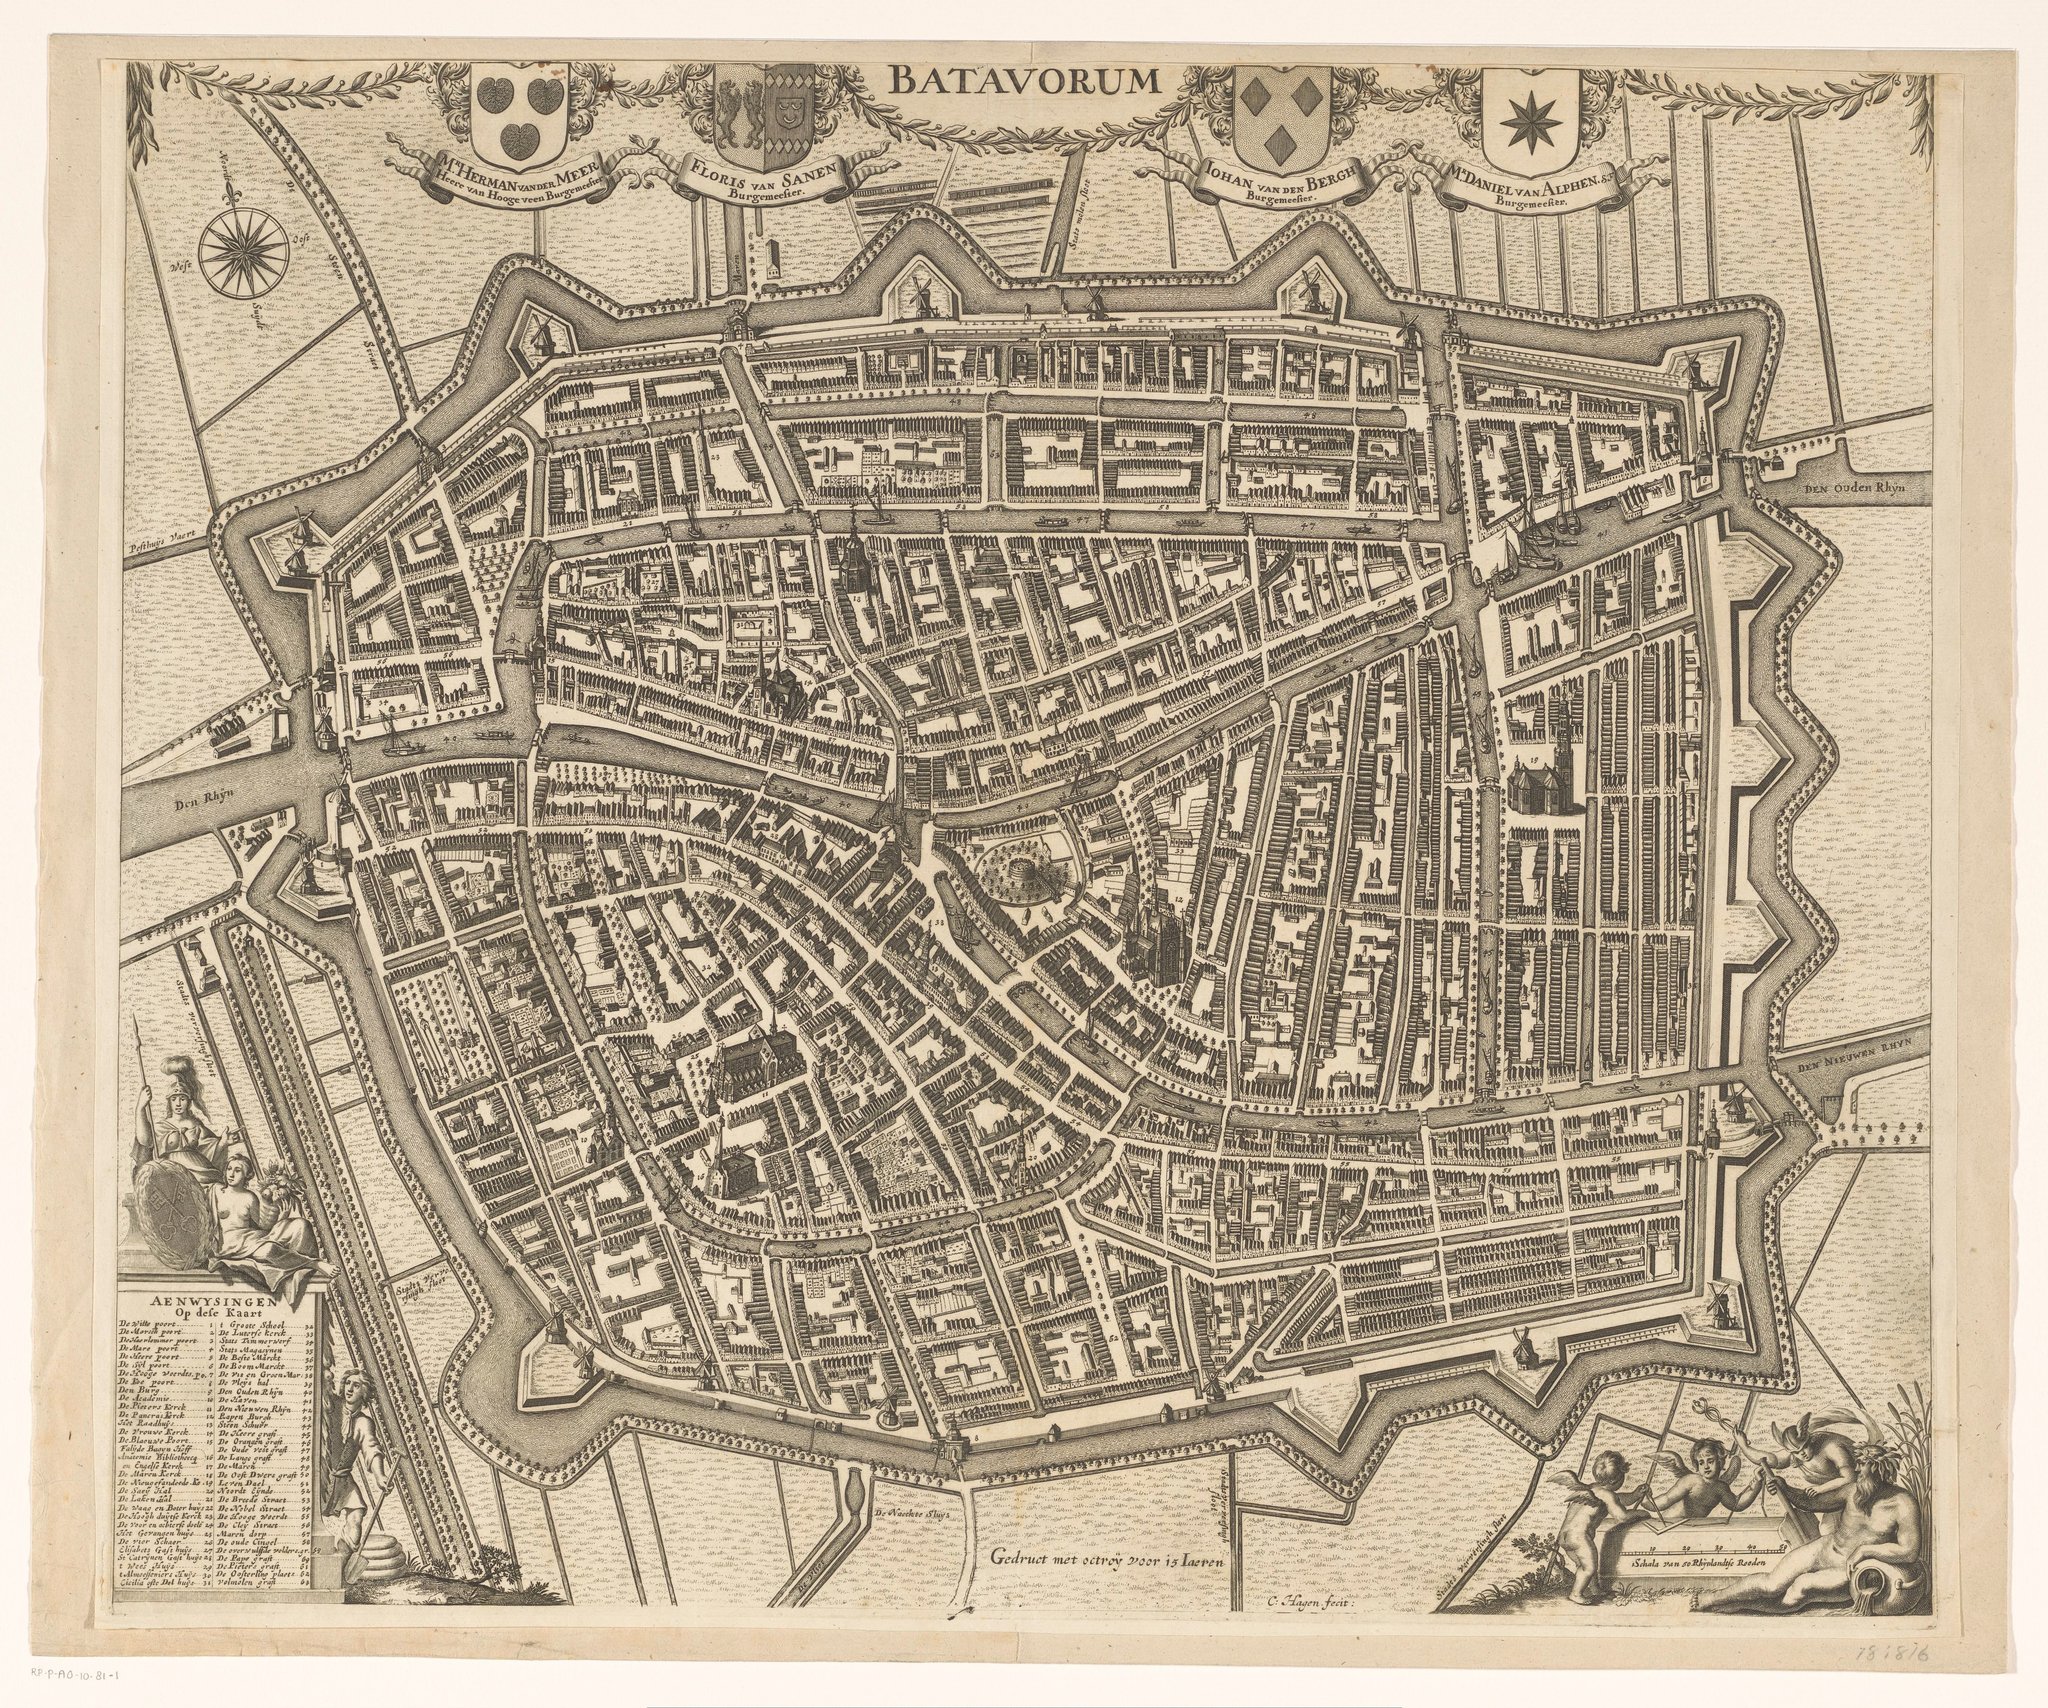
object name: print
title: Lugdunum Batavorum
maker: christiaan hagen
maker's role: draughtsman, print maker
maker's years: 1635-1707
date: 1675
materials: paper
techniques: engraving, etching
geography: amsterdam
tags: coat of arms (as symbol of the state, etc.) (+ city; municipal), (story of) mercury (hermes), river-gods, maps of cities, armorial bearing, heraldry, instruments used in geodesy, surveying instruments, leiden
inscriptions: collector's mark: Lugt 2228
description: Deze prent is oorspronkelijk bedoeld als onderdeel van de Kleine Hagen. Voor een digitaal gemonteerde versie van de Kleine Hagen zie koepelrecord. Voor een digitaal gemonteerde versie van rand van de Grote Hagen zie RP-P-2016-1124. Voor een digitaal gemonteerde versie van een latere druk van de plattegrond van de Grote Hagen zie RP-P-AO-10-18.